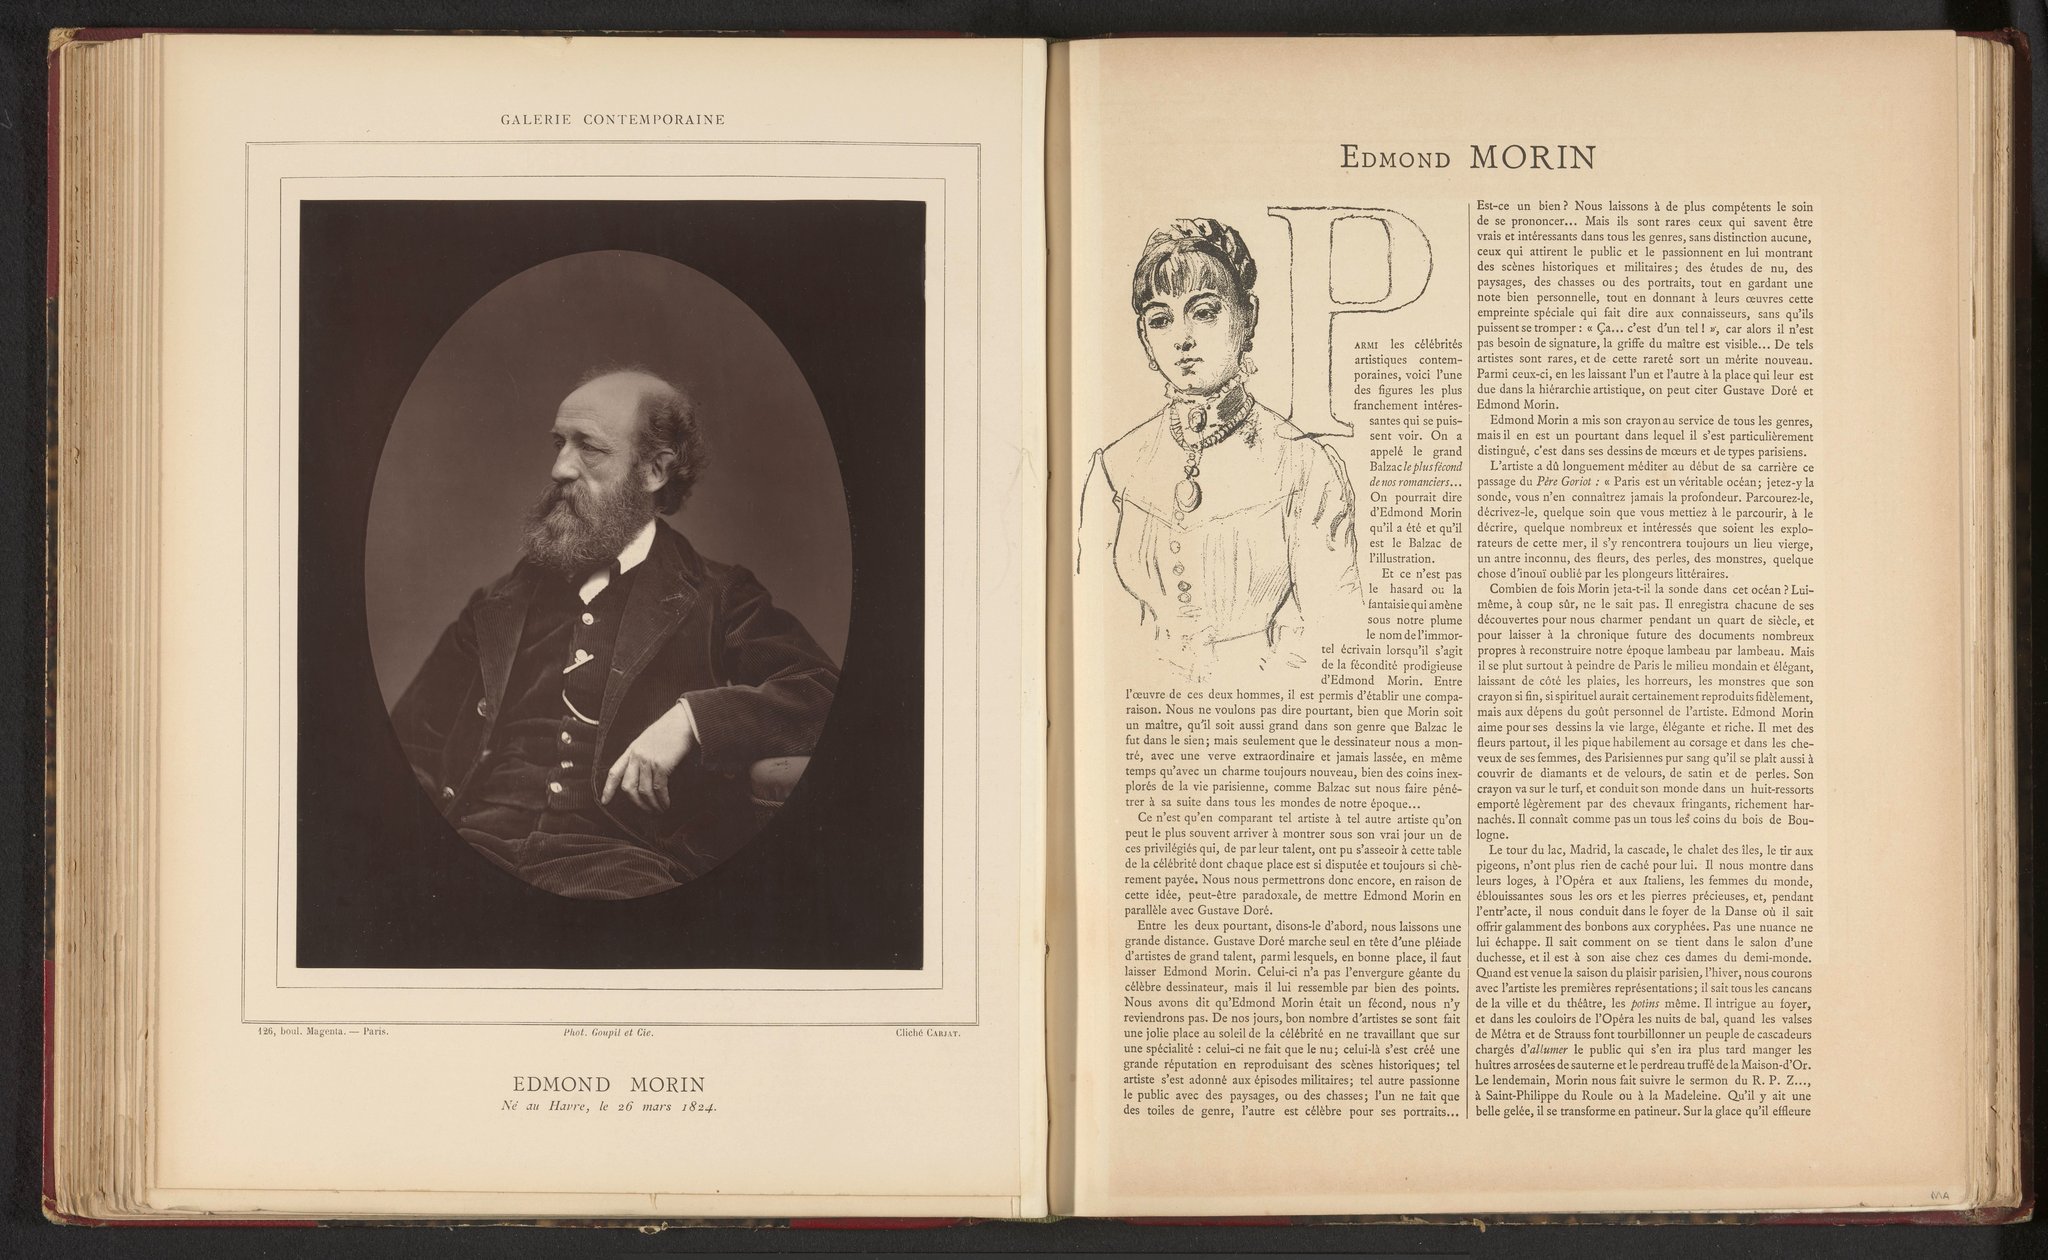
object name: photomechanical print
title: Fotoreproductie van een tekening door vermoedelijk Edmond Morin, voorstellend een groep mensen voor het hoofd van het Vrijheidsbeeld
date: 1876-1879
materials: paper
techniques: autotype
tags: drawing, sketch, monument, statue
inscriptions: inscription: ‘28 juin’